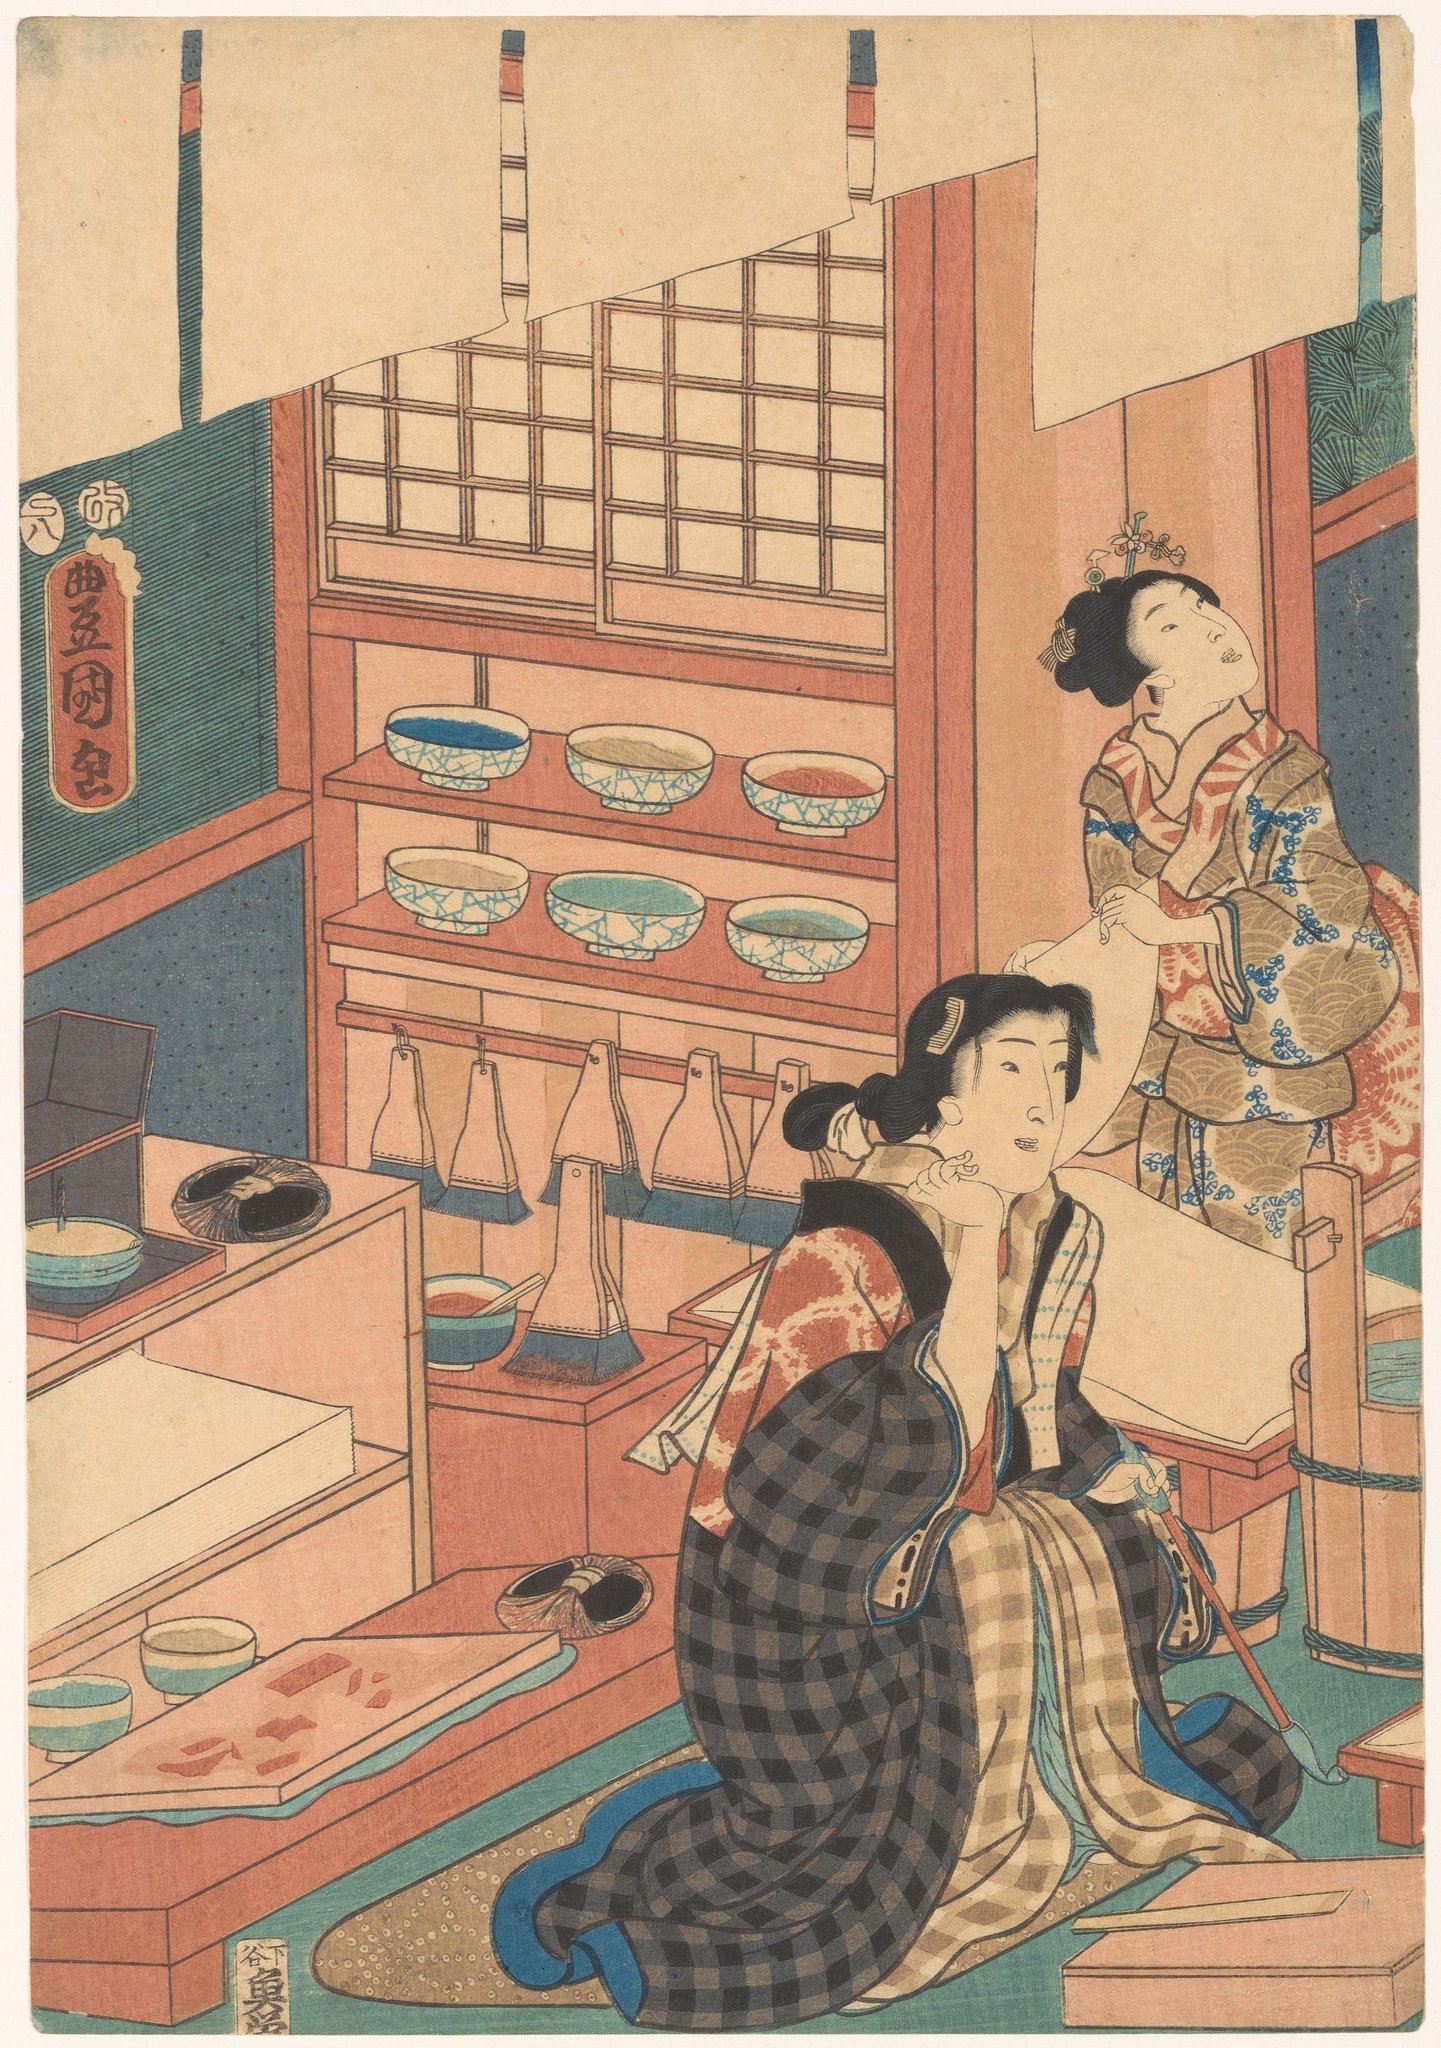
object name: print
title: Vrouwen maken prenten (linkerdeel)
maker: utagawa kunisada (i)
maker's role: print maker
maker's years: 1786-1865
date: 1796-1865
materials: paper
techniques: blind stamped, woodcut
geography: japan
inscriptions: collector's mark: Lugt 2228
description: Linkerdeel van een drieluik met vrouwen die prenten maken.